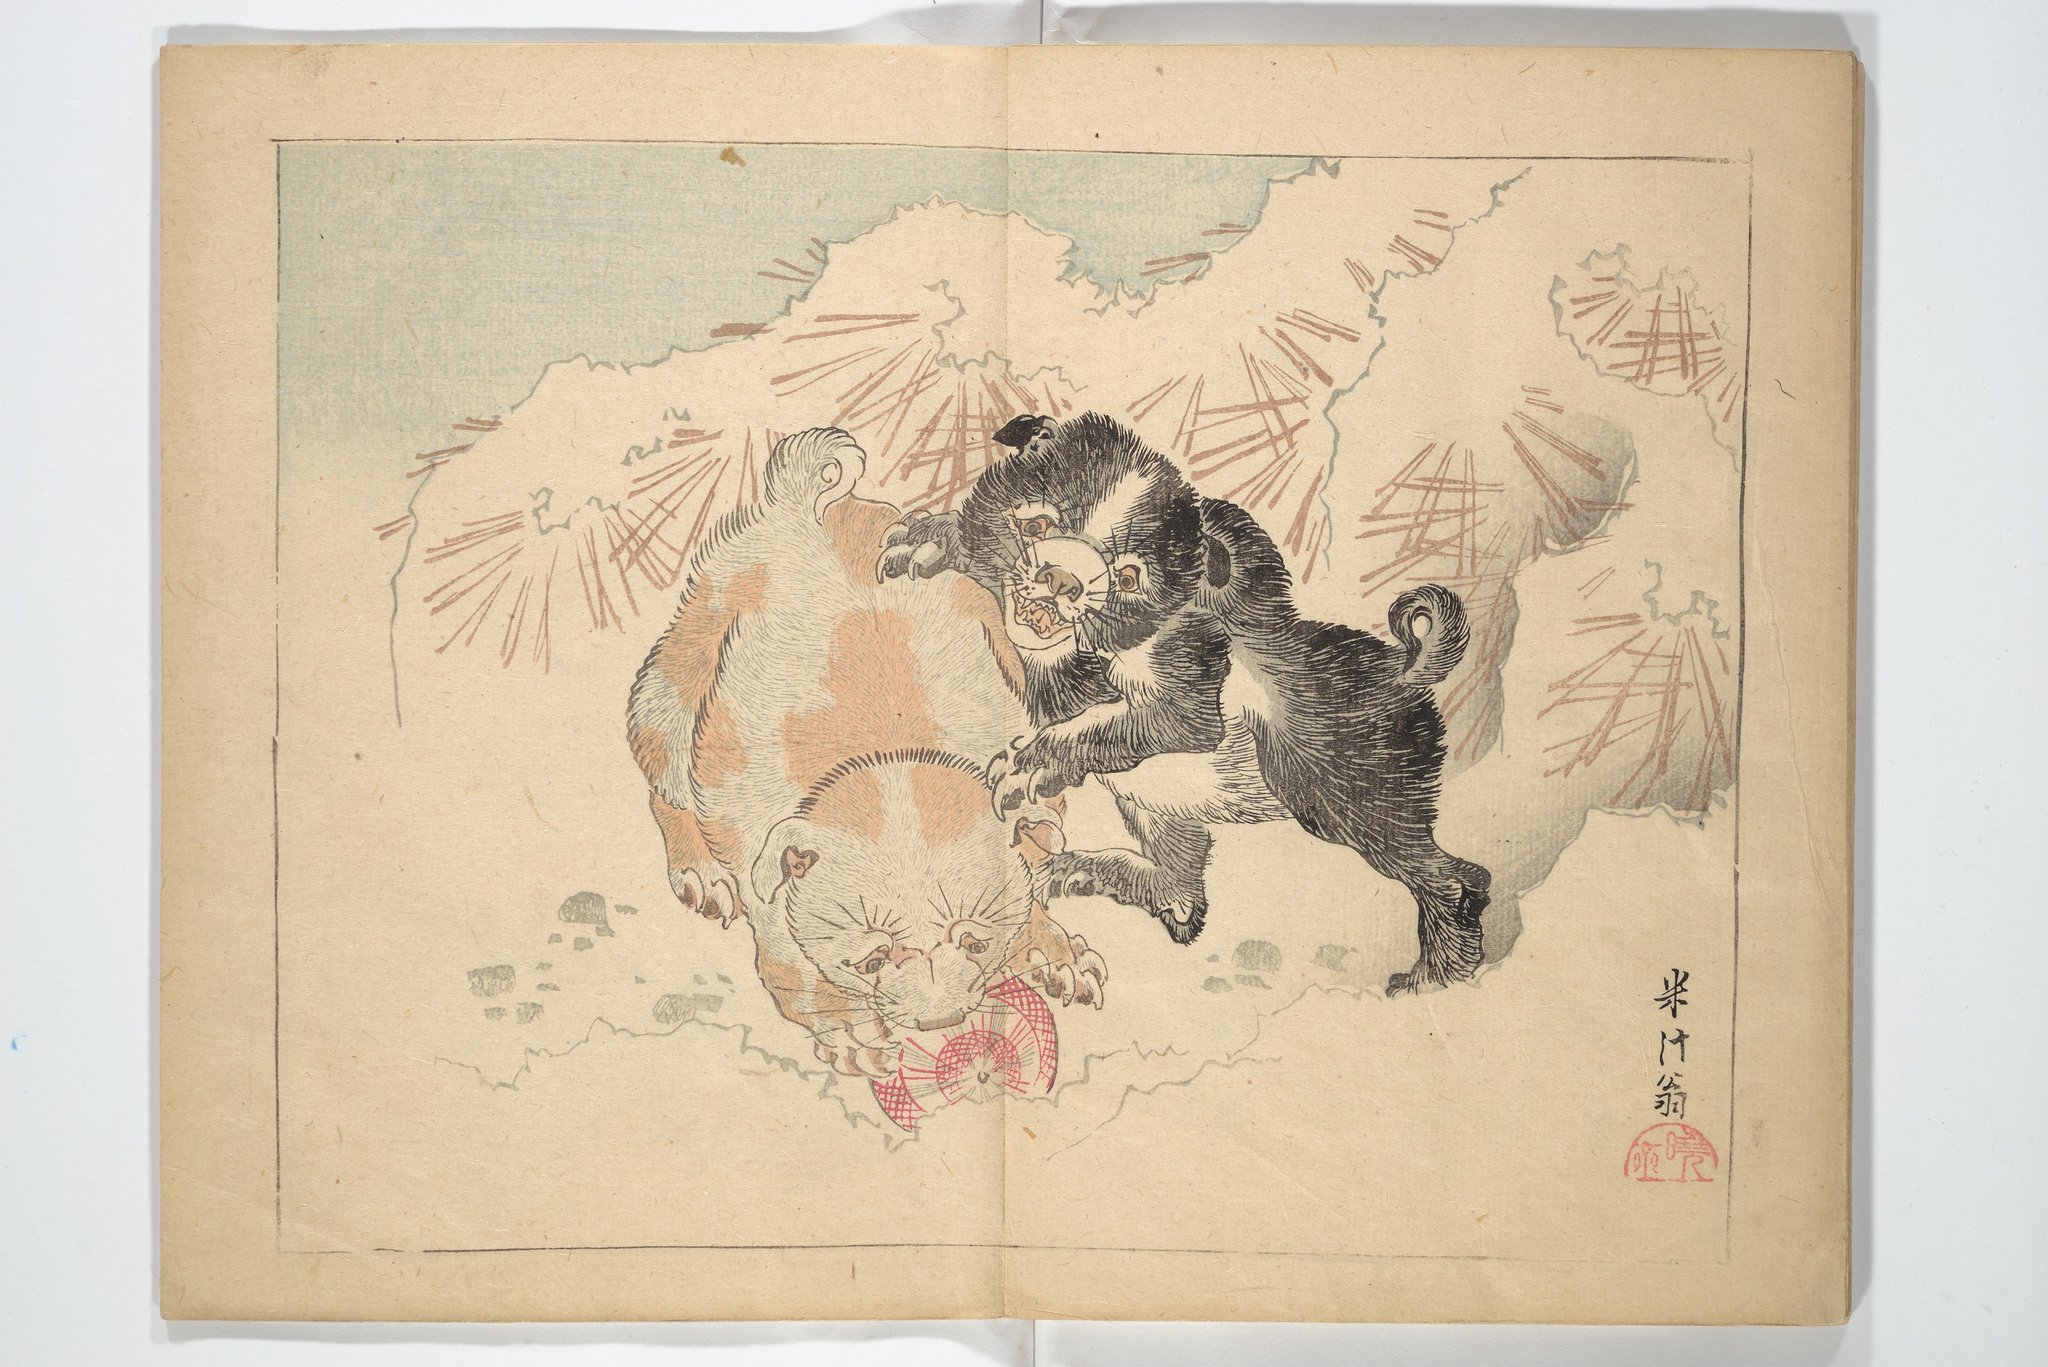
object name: illustrated book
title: Kyōsai’s Drawings for Pleasure (Kyōsai rakuga) 暁齋樂画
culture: japanese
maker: kawanabe kyōsai 河鍋暁斎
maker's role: artist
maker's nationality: japanese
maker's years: 1831-1889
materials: ink, paper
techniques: woodblock print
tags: animals,playing